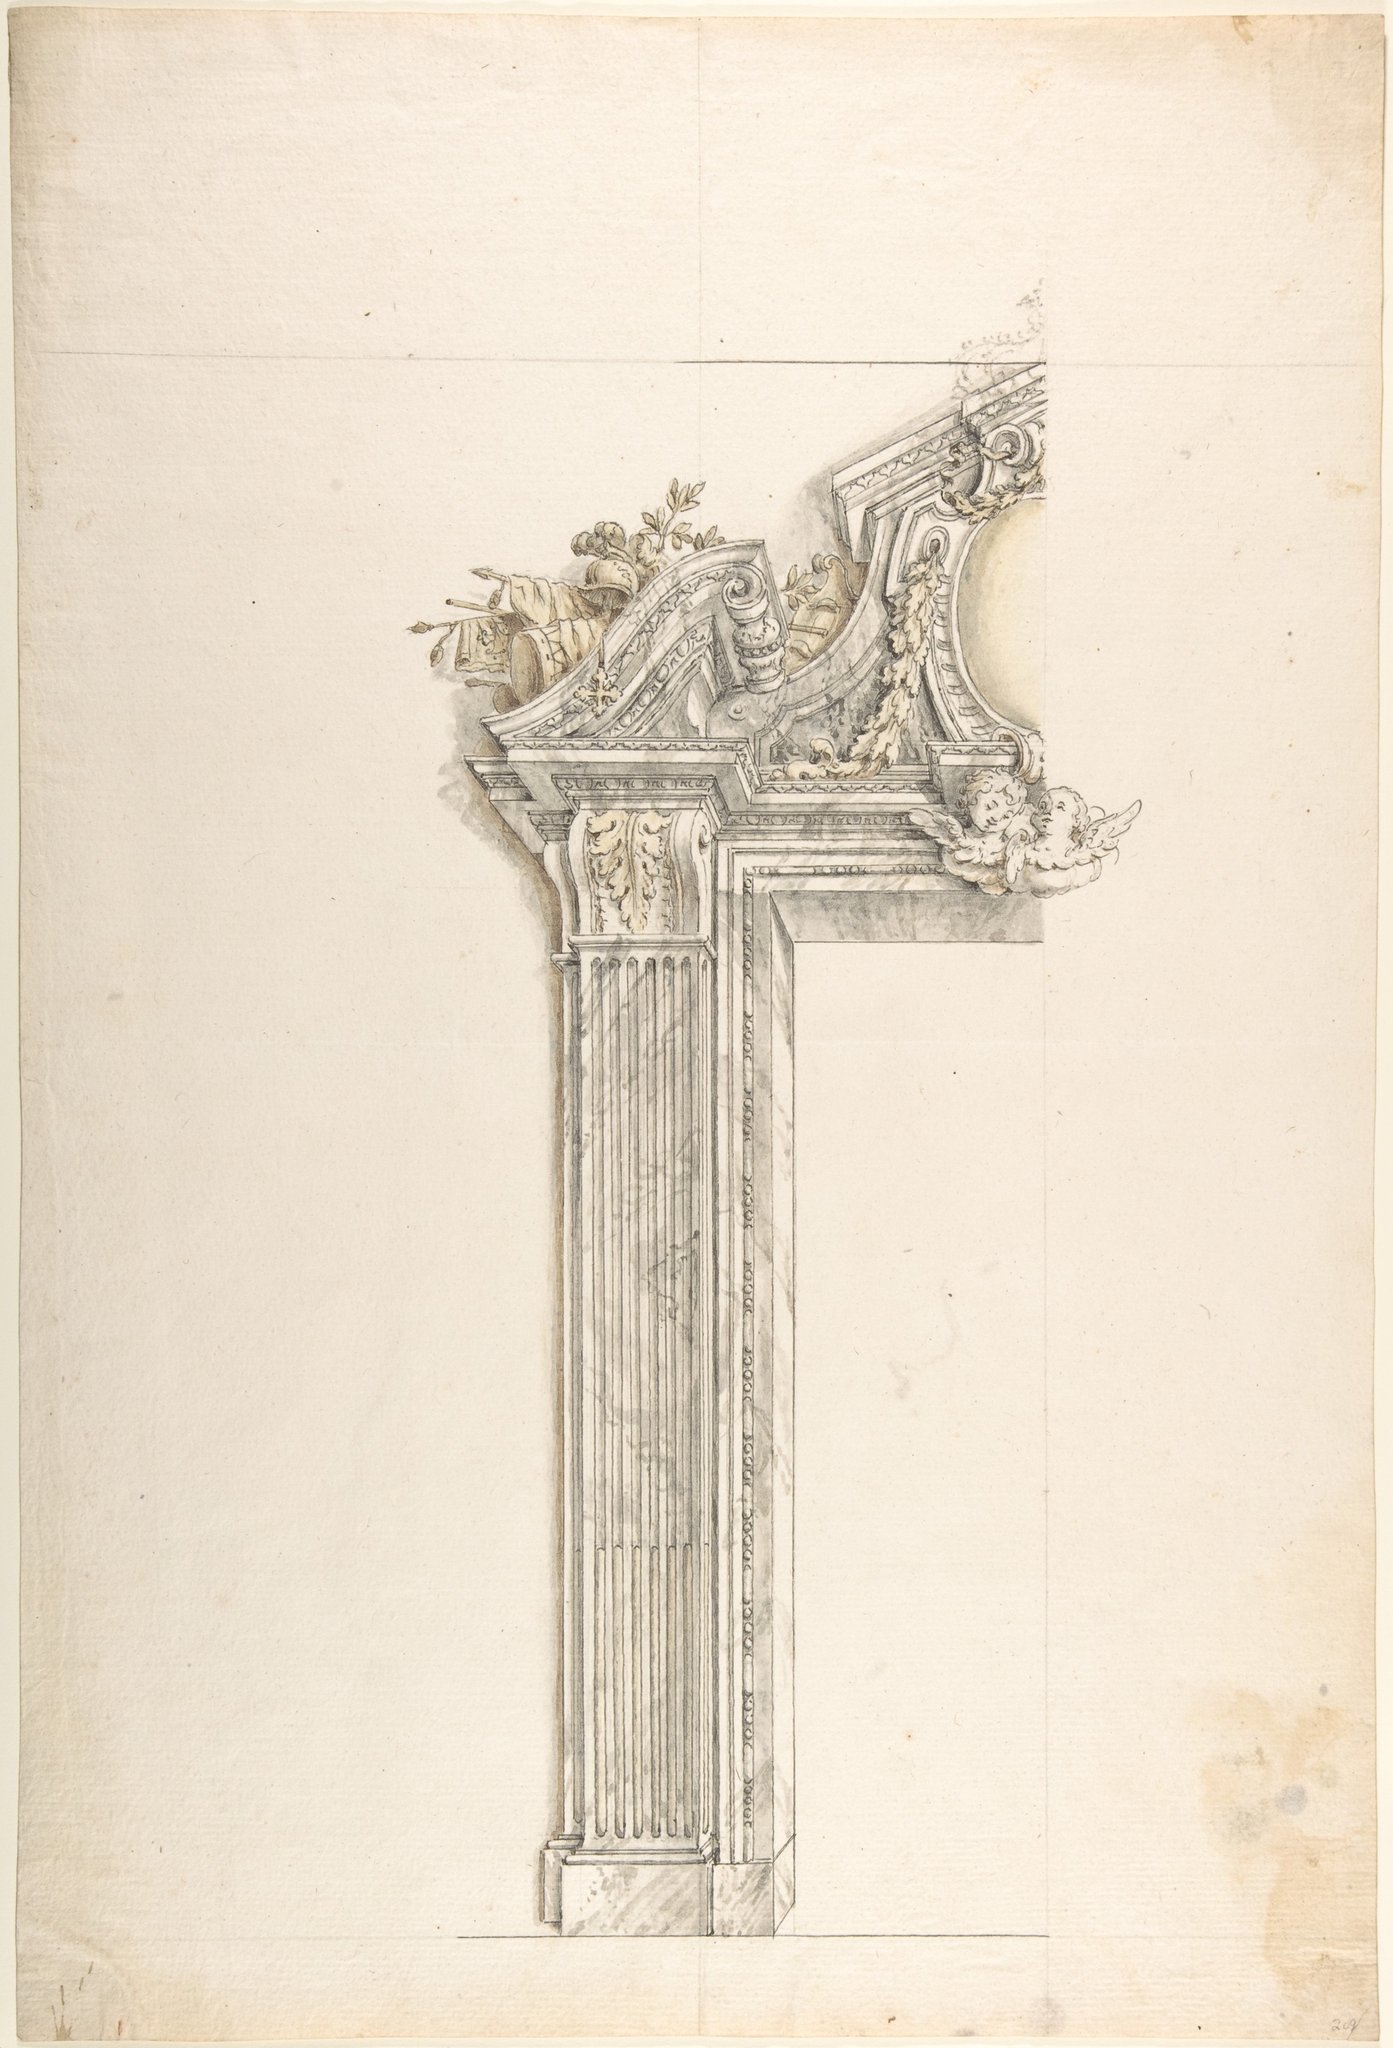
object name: drawing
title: One Half Design for a Doorway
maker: anonymous, italian, piedmontese, 18th century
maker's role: artist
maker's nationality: italian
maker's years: 1700-1800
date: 1700-1780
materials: graphite, ink, drawing material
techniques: brush, pen, wash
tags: architecture